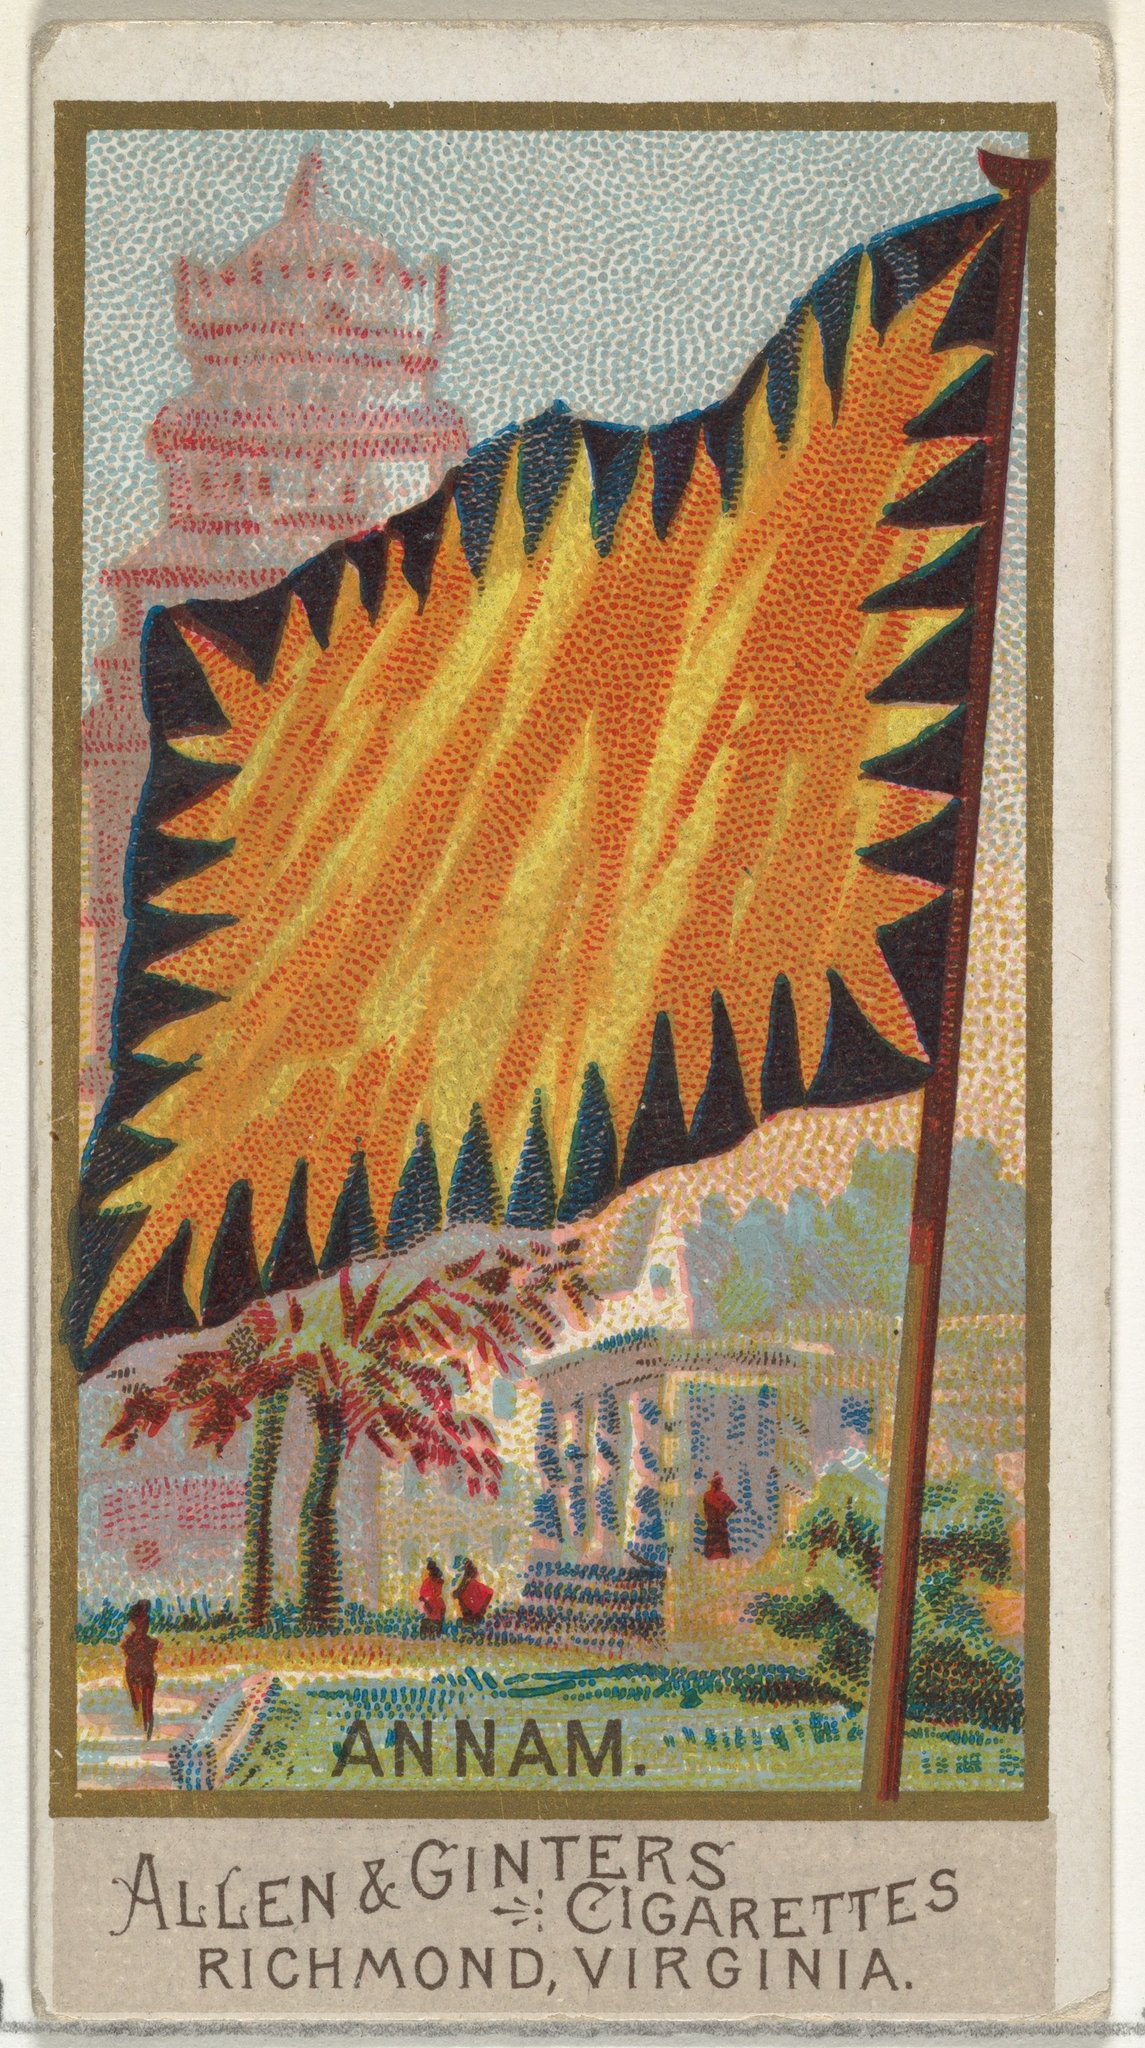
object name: print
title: Annam, from Flags of All Nations, Series 2 (N10) for Allen & Ginter Cigarettes Brands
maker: allen & ginter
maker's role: publisher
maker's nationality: american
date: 1890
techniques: color lithograph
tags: flags